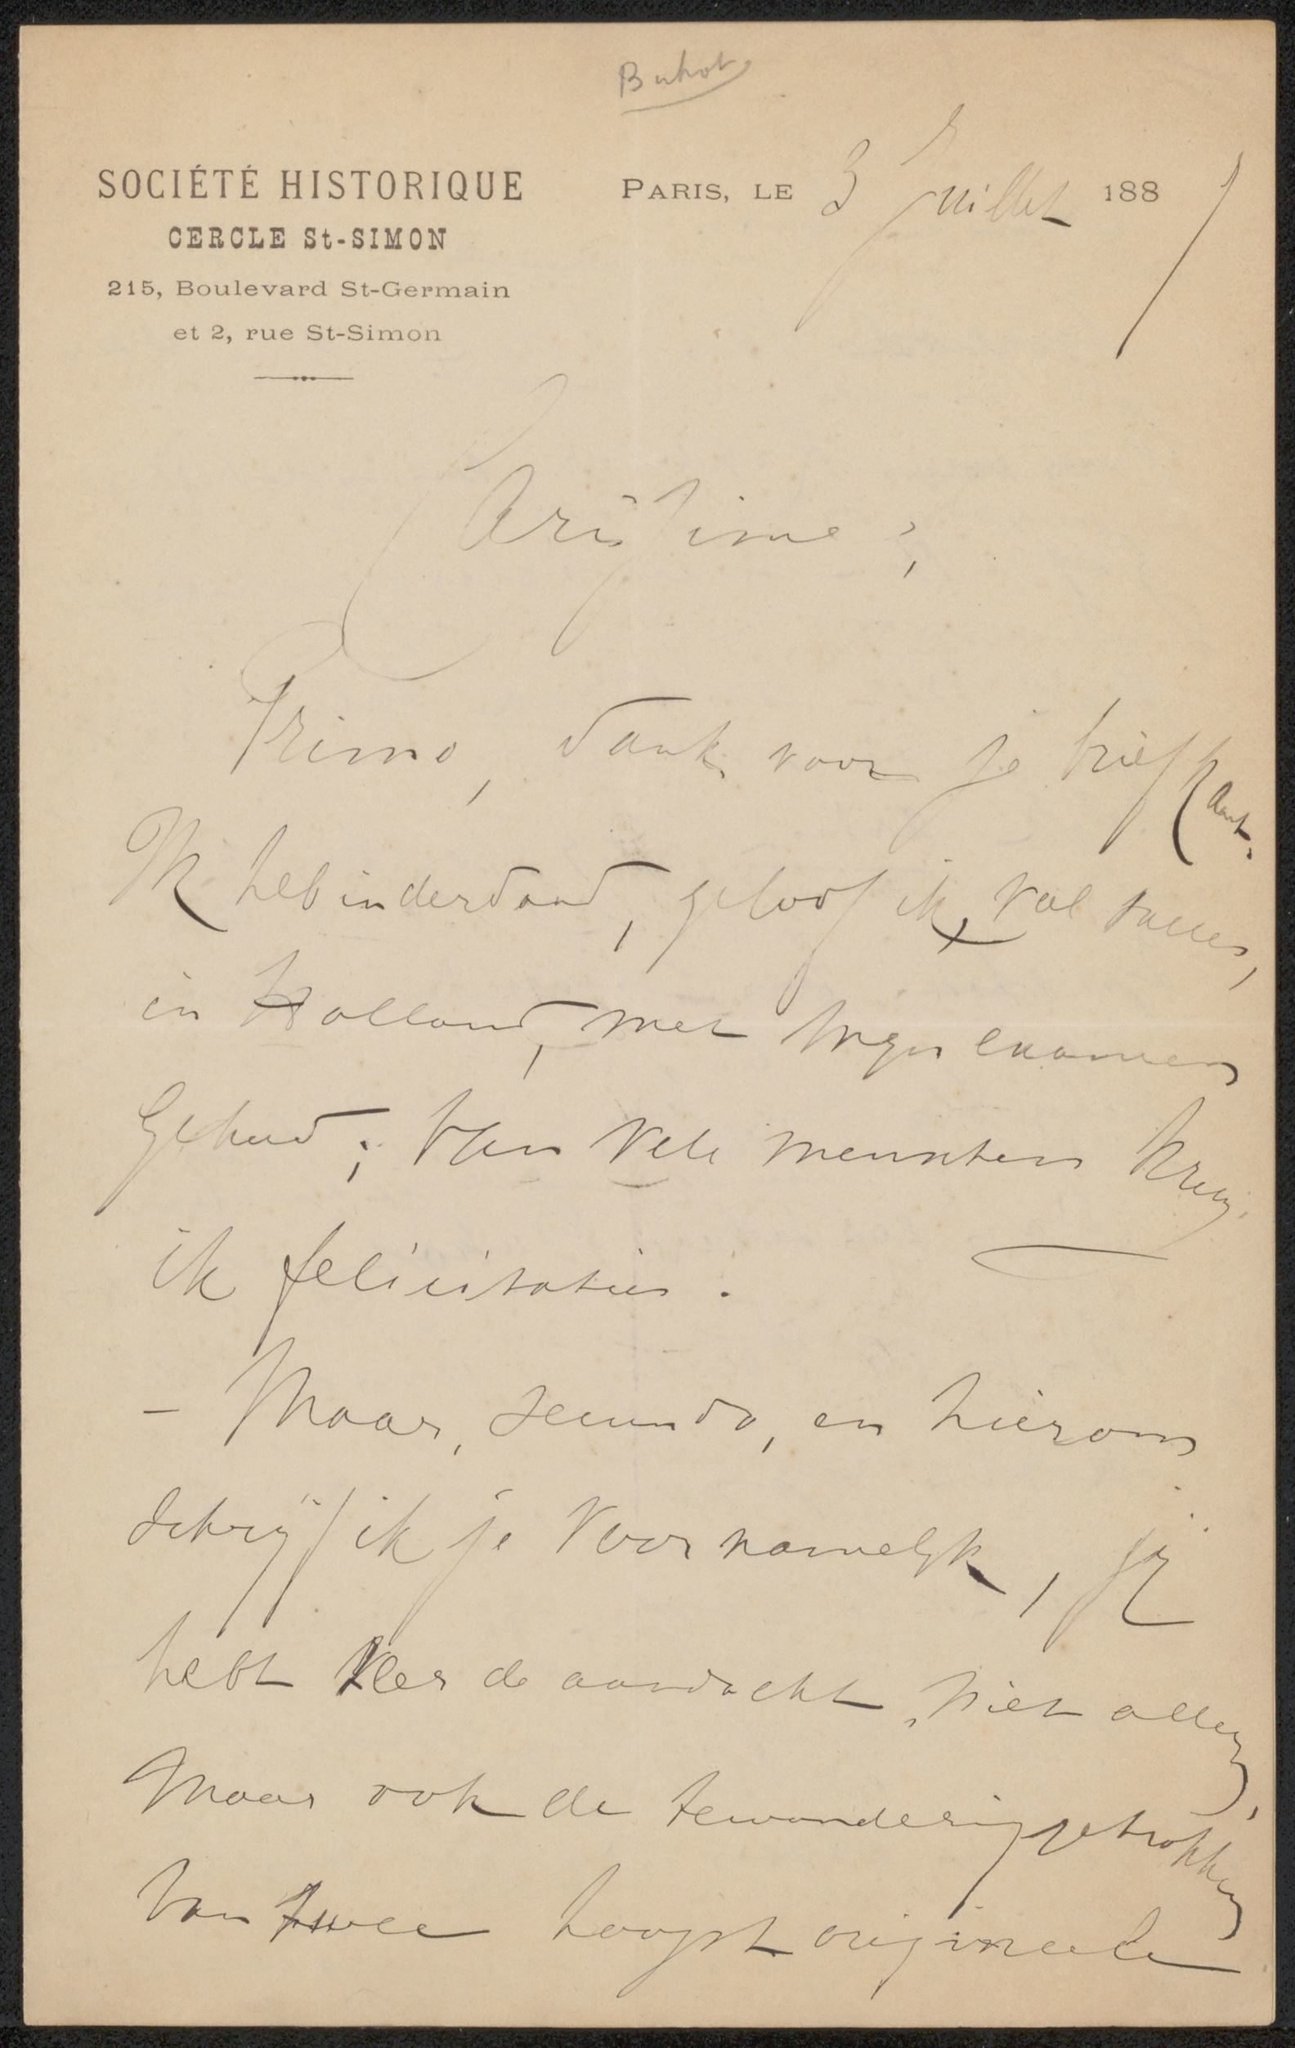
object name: letter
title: Brief aan Philip Zilcken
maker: adriaan pit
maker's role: print maker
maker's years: 1860-1944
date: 1887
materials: ink, paper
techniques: pen, printing, writing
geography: paris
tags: arnhem, anton mauve, jacob maris, marinus van der maarel, alexis forel, paris, félix hilaire buhot, print maker, draughtsman, félicien rops, frederick keppel, painter, philip zilcken, the graphic arts, exhibition ~ art, holland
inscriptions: collector's mark: ‘RPK’